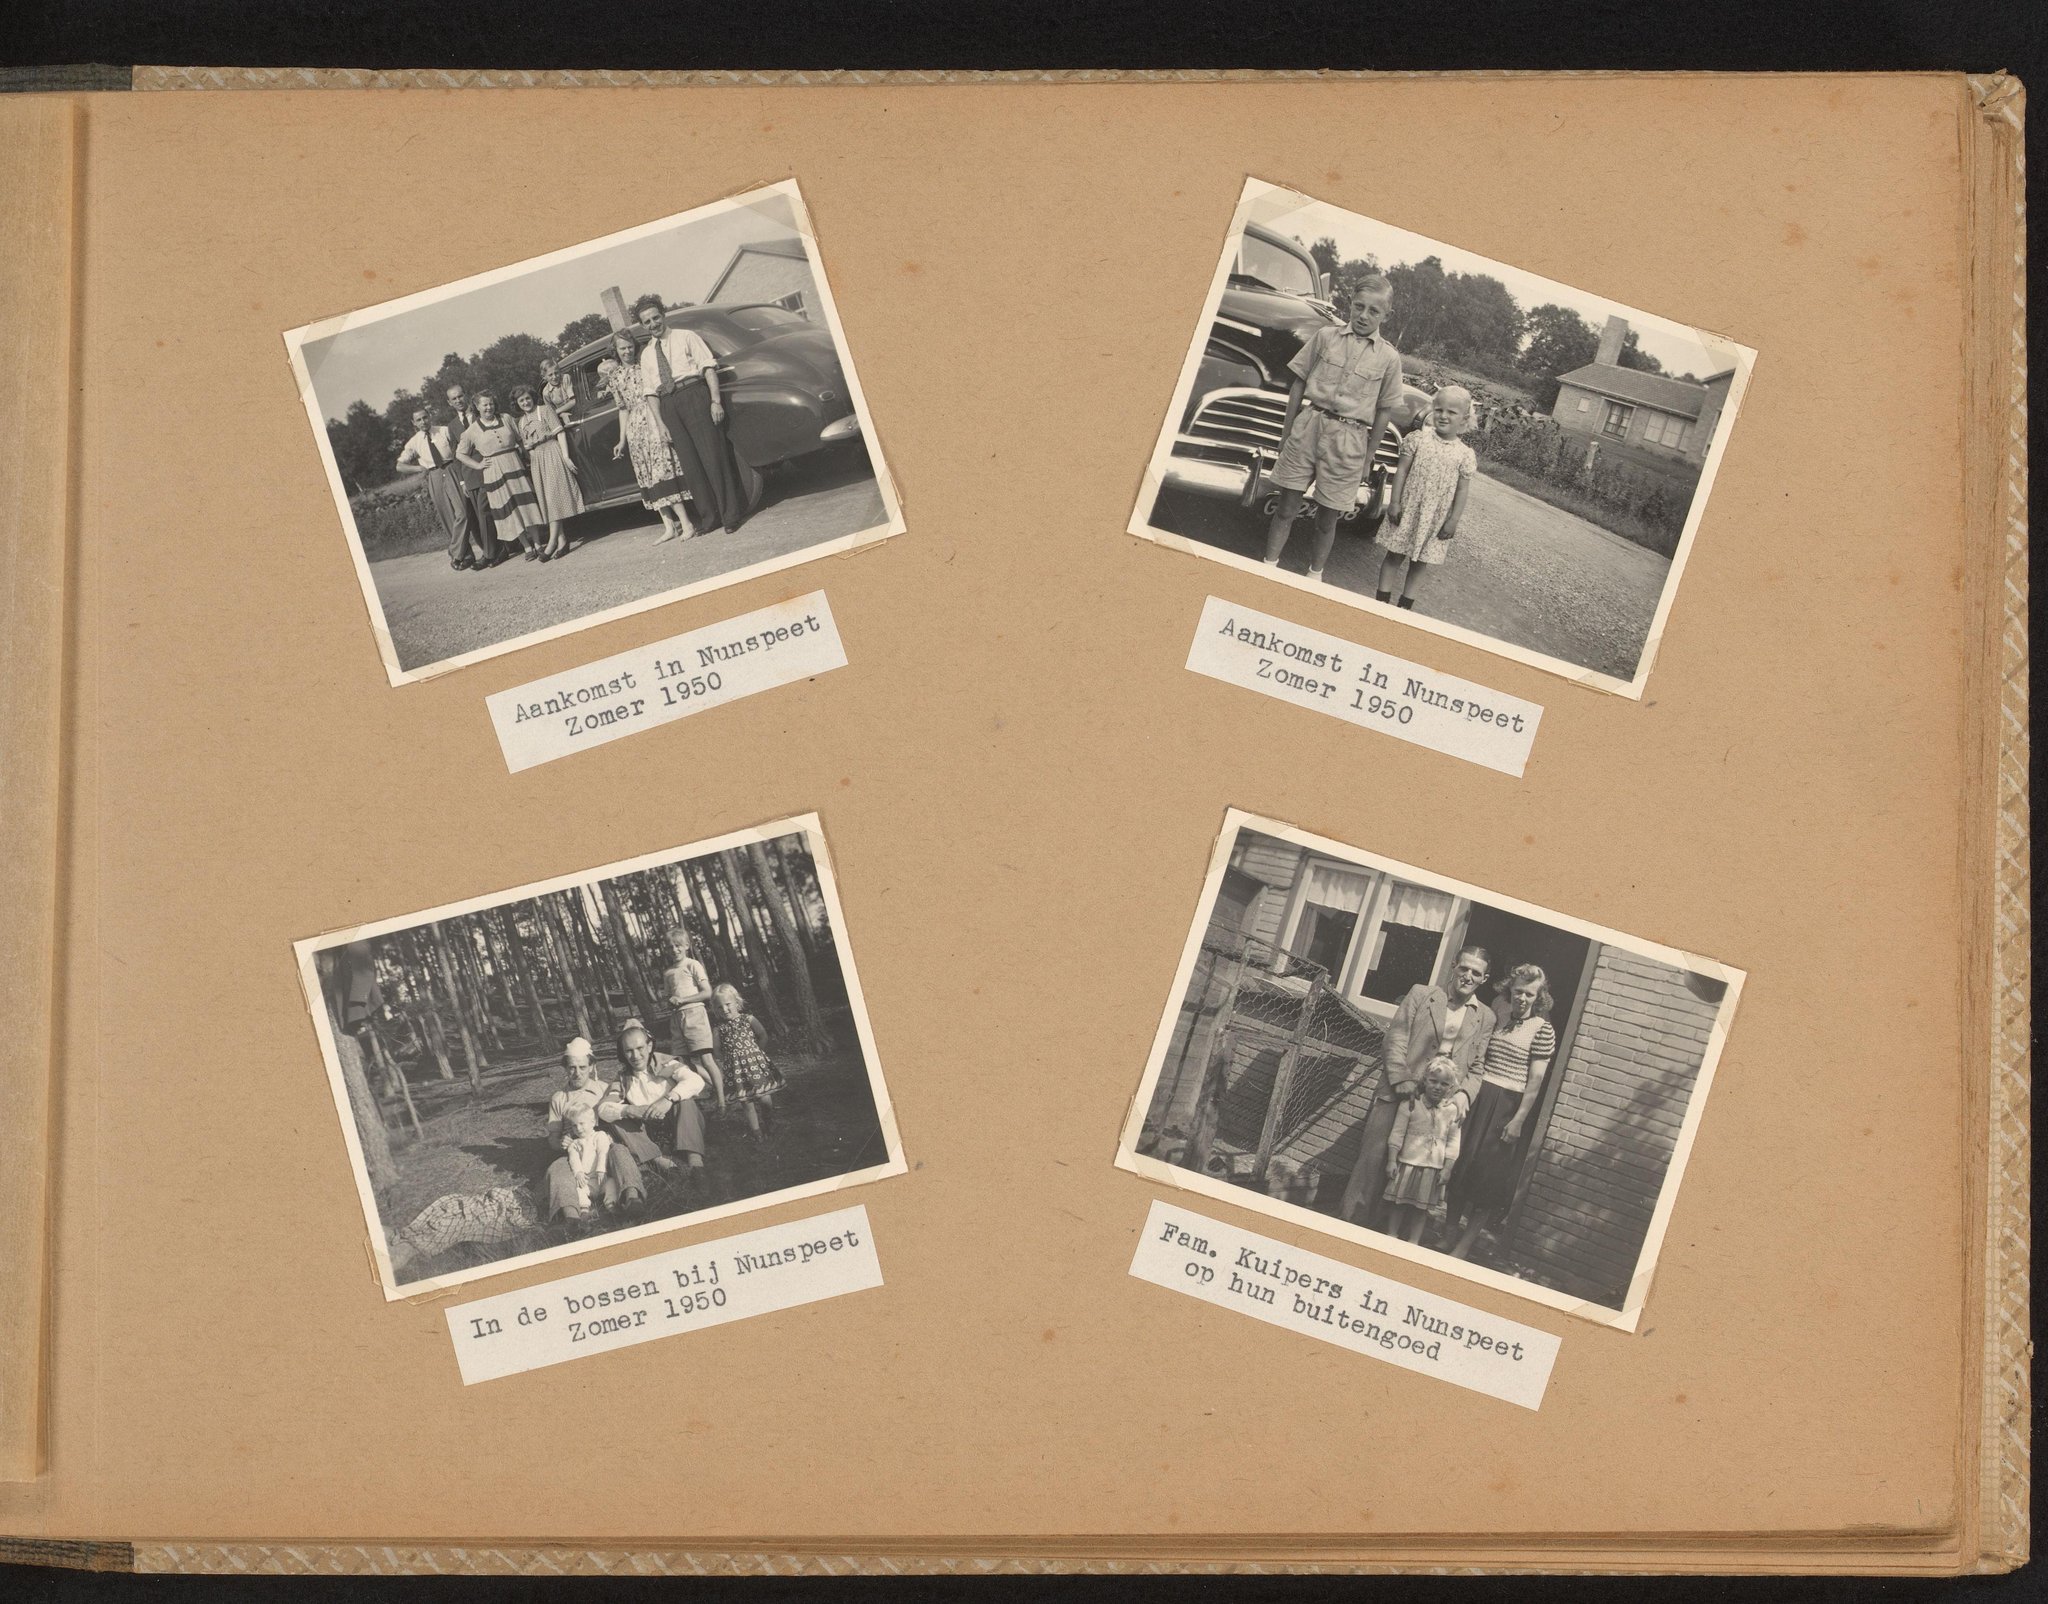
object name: photograph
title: Nunspeet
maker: Anonymous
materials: paper, photographic support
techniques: gelatin silver print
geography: netherlands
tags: the family travelling, on holiday, outing, pleasure trip, automobile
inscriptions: inscription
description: Albumblad met vier foto's van een vakantie met het gezin in Nunspeet, zomer 1950. Onder de foto's uitgeknipte papiertjes met getypte opschriften. Onderdeel van het tweede fotoalbum met foto's van familievakanties in Nederland, België, Luxemburg en Frankrijk in 1950-1951.